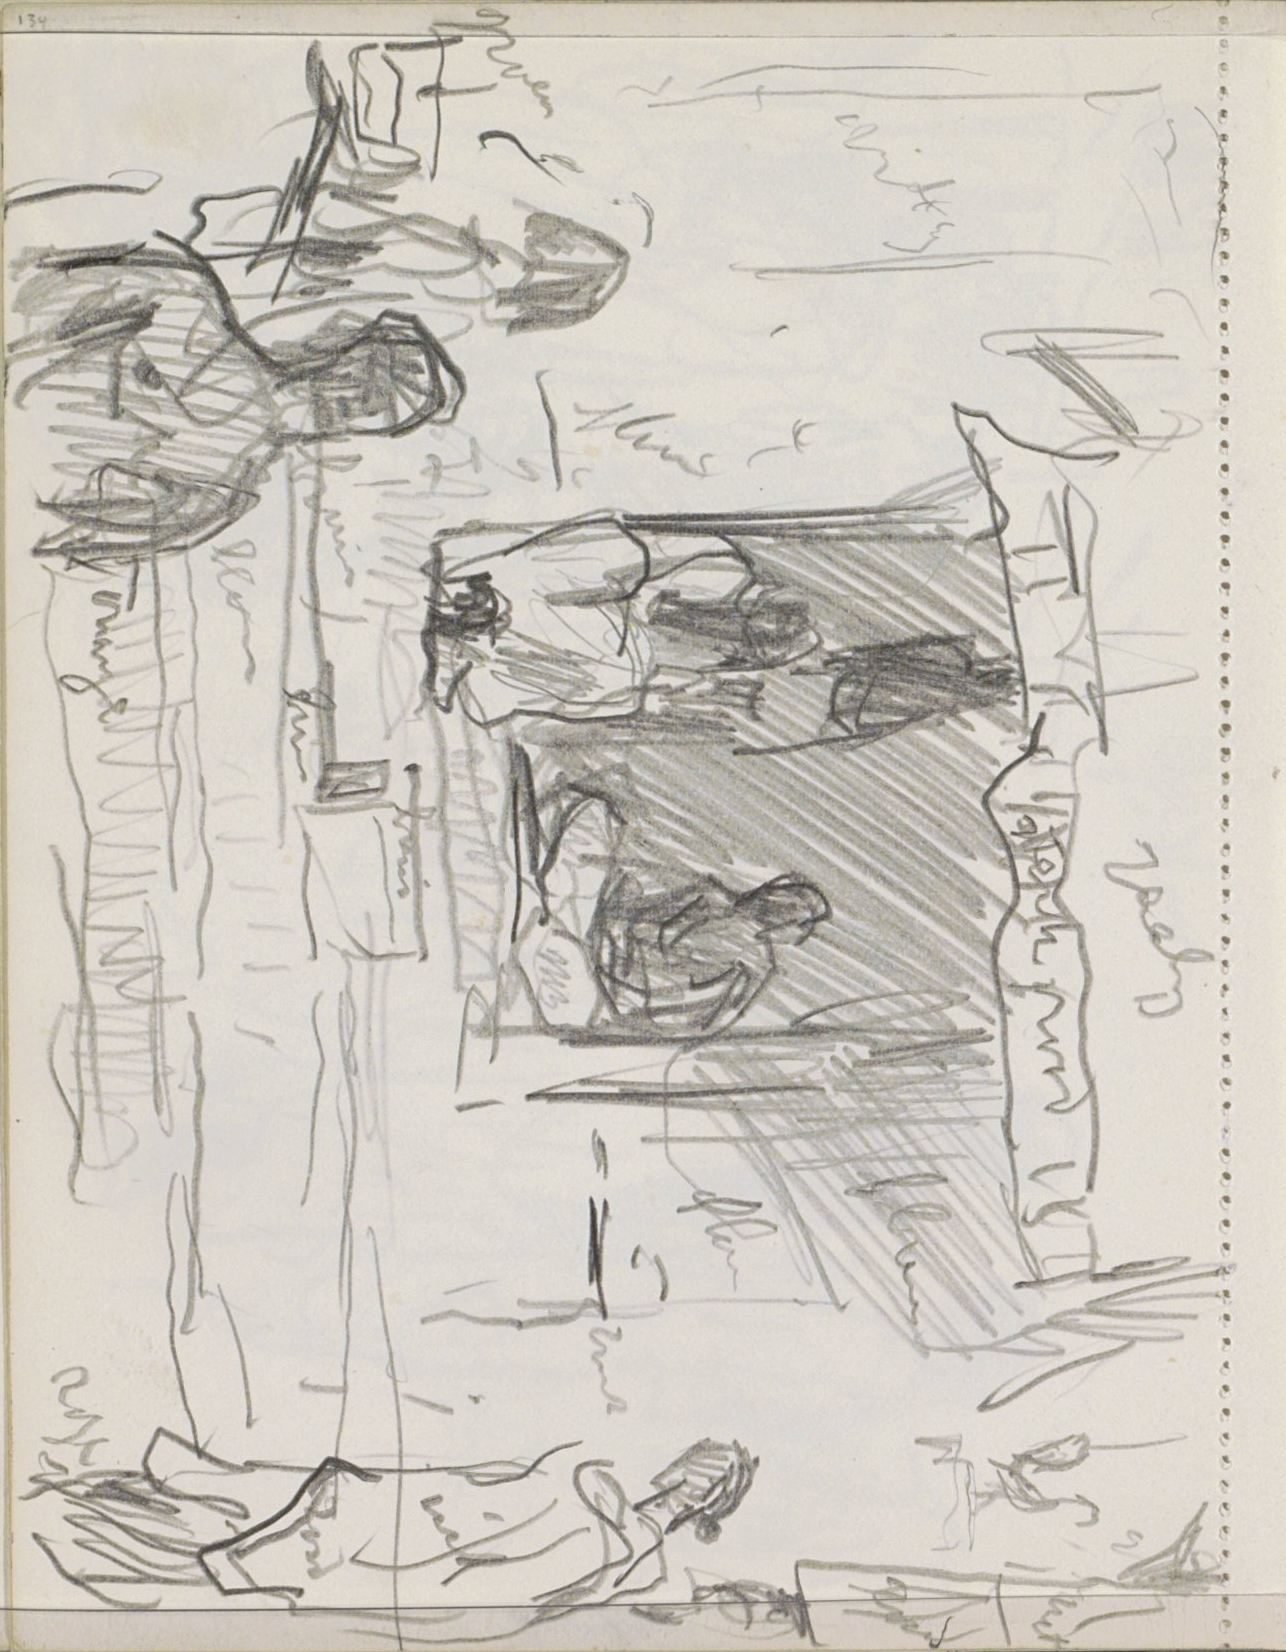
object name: sketchbook leaf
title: Straat met zittende Indiërs in een nis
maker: marius bauer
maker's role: draughtsman, print maker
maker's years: 1867-1932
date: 1924-1925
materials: paper, pencil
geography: india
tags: urban housing, sitting figure, asiatic races and peoples: indians, street (+ city(-scape) with figures, staffage)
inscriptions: kleurnotitie, handgeschreven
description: Een trap leidt naar de nis, die vermoedelijk deel uitmaakt van een huis. Op de straat lopen enkele figuren. Pagina 134 uit een schetsboek met 75 bladen.